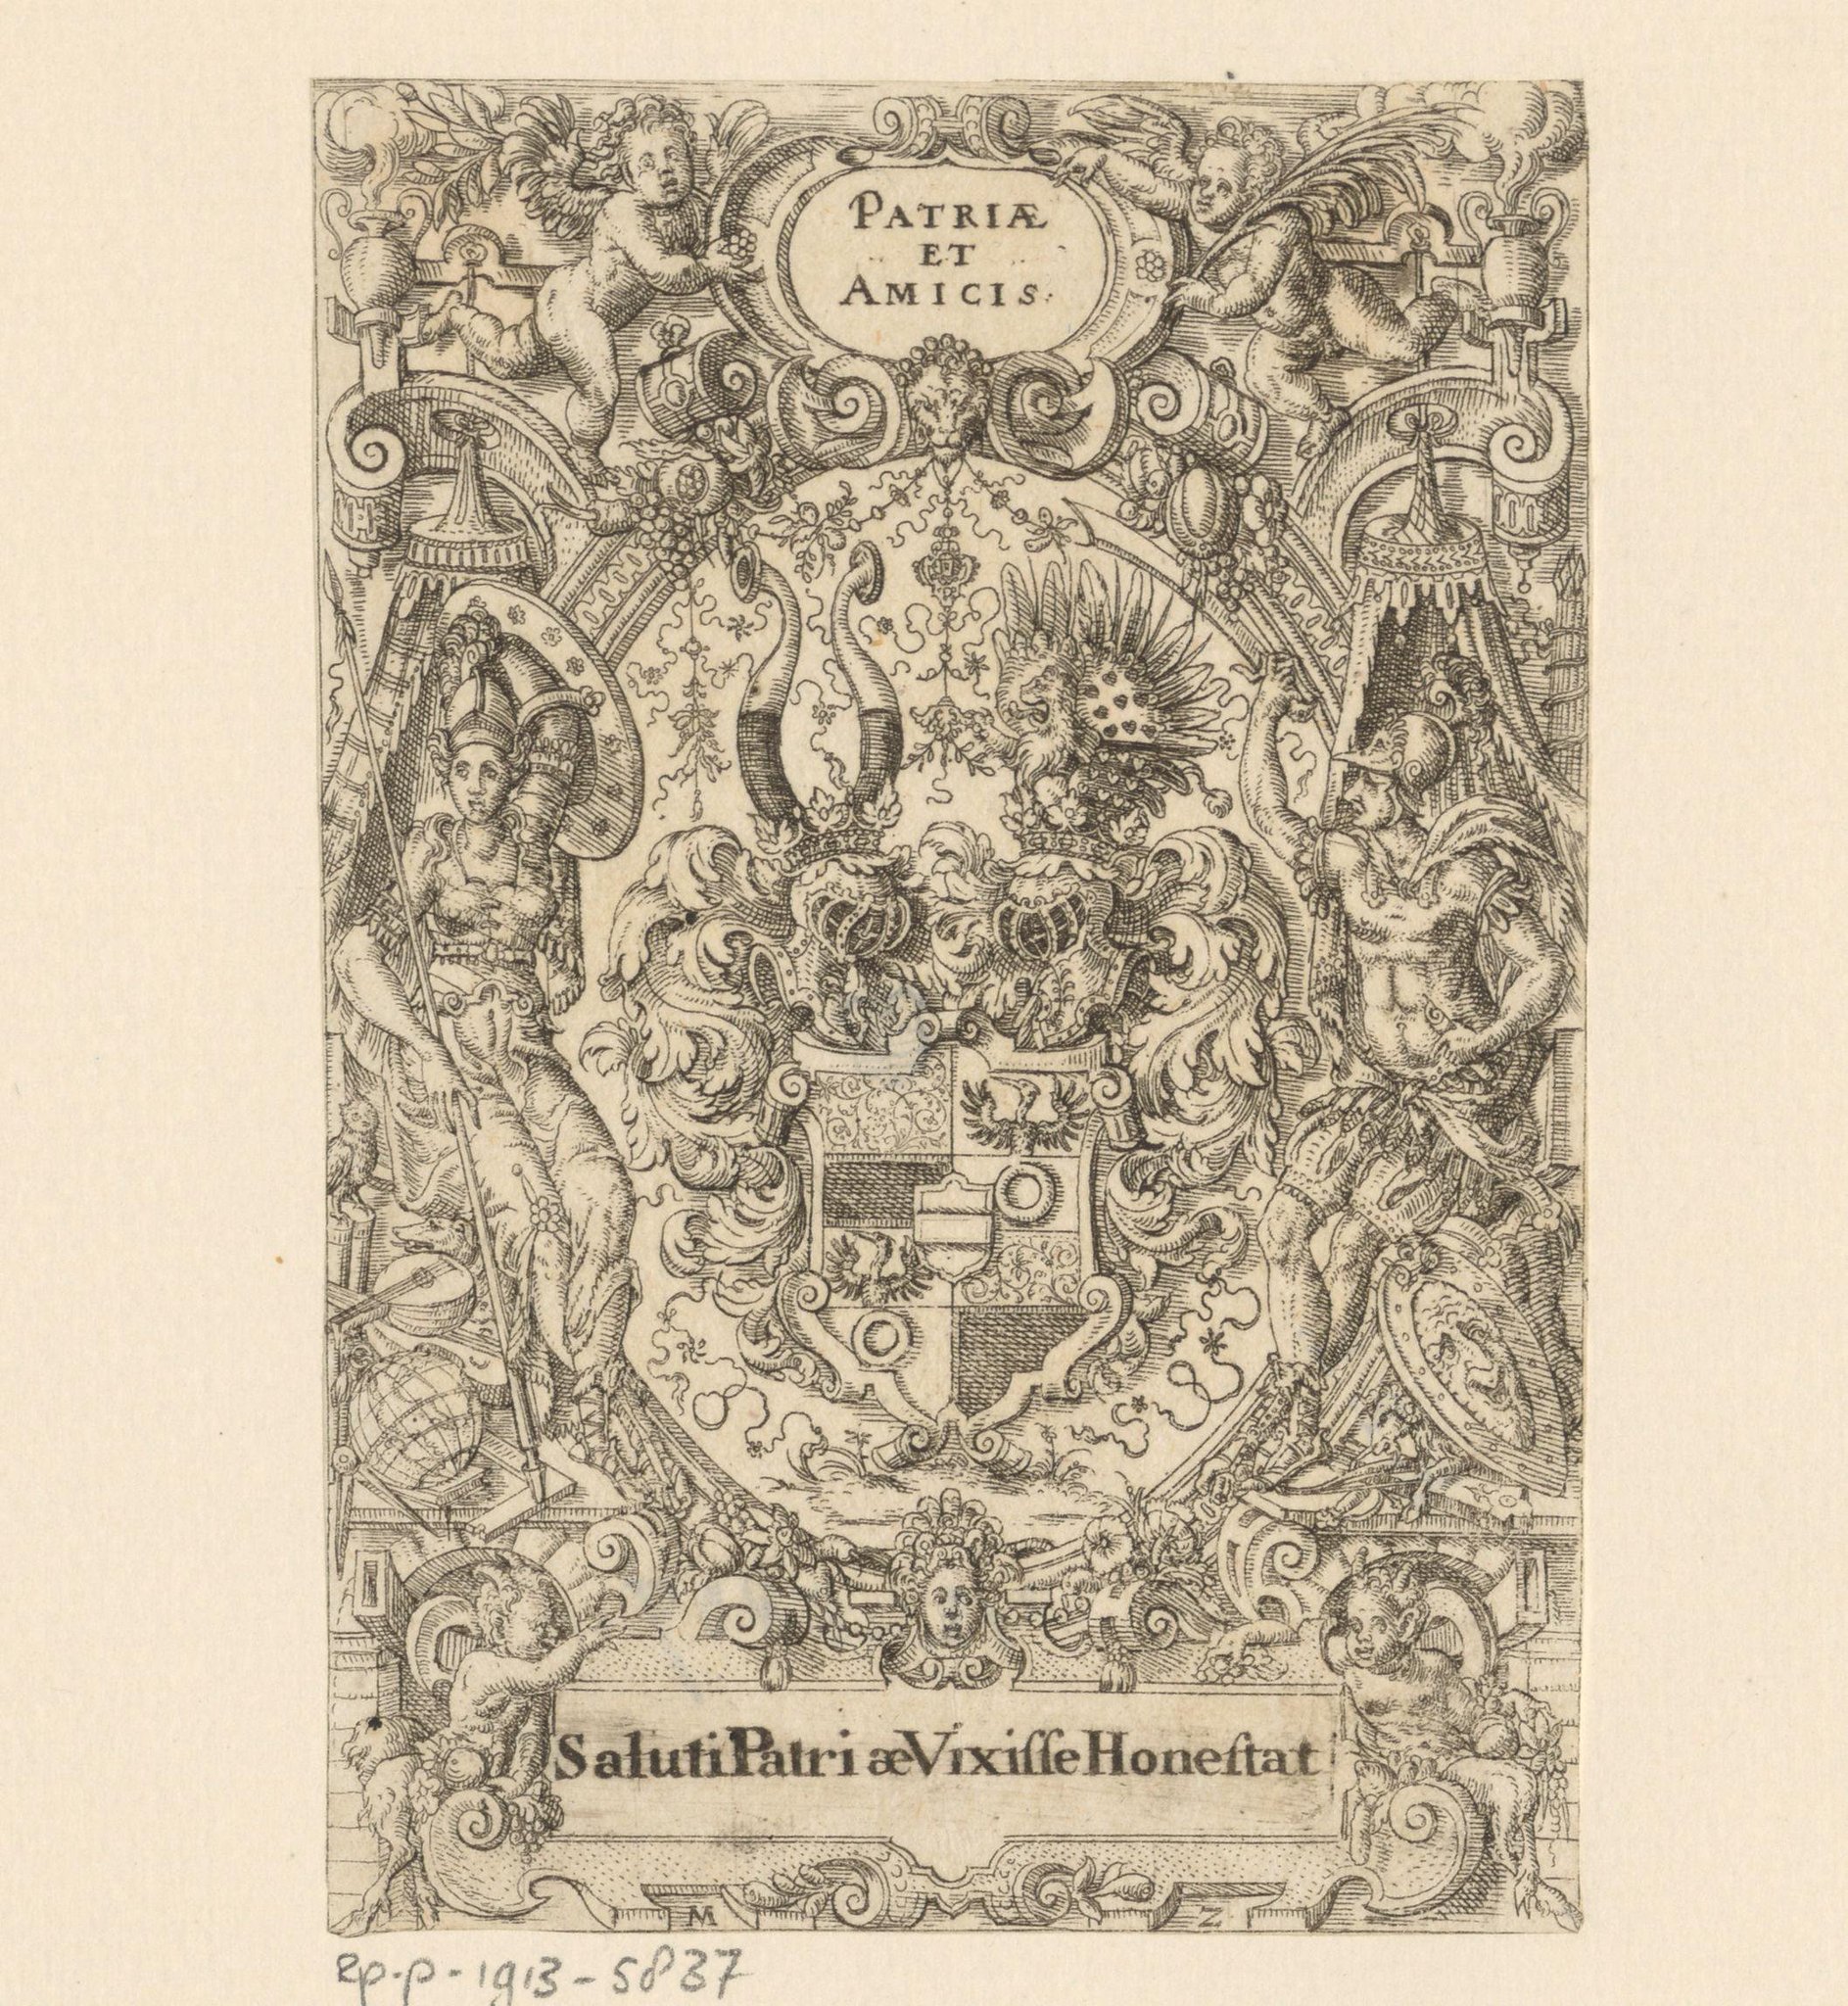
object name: bookplate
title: Patriae et Amicis / Saluti Patri ae Vixisse Honestat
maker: mathis zündt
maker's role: goldsmith, print maker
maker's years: 1498-1572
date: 1508-1572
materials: paper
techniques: etching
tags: armorial bearing, heraldry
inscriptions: collector's mark: Lugt 2233, collector's mark: Lugt 2760